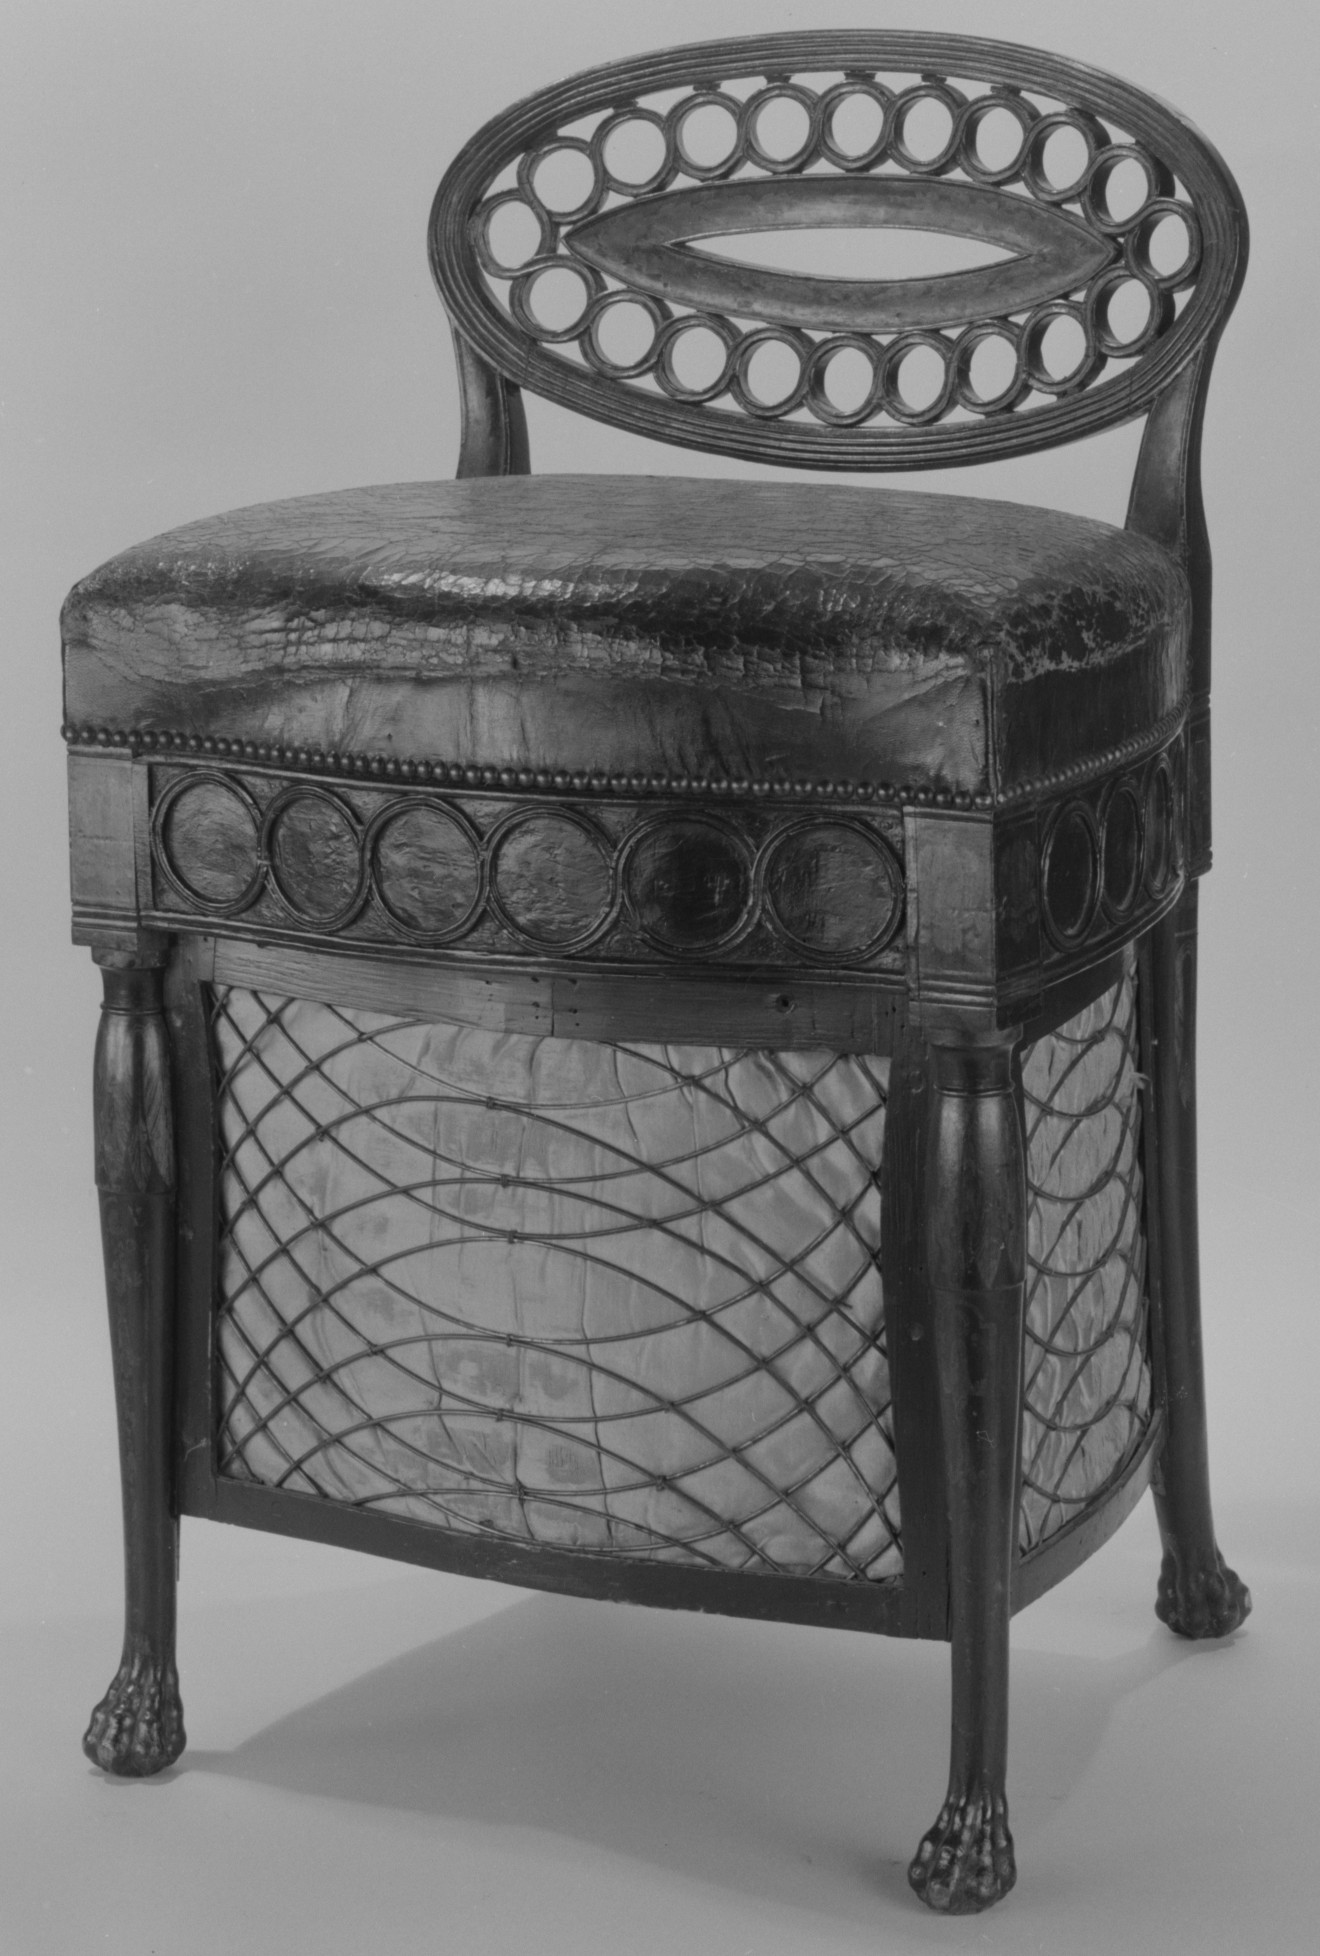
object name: porter's chair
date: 1801-1833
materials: leather, silk, wood